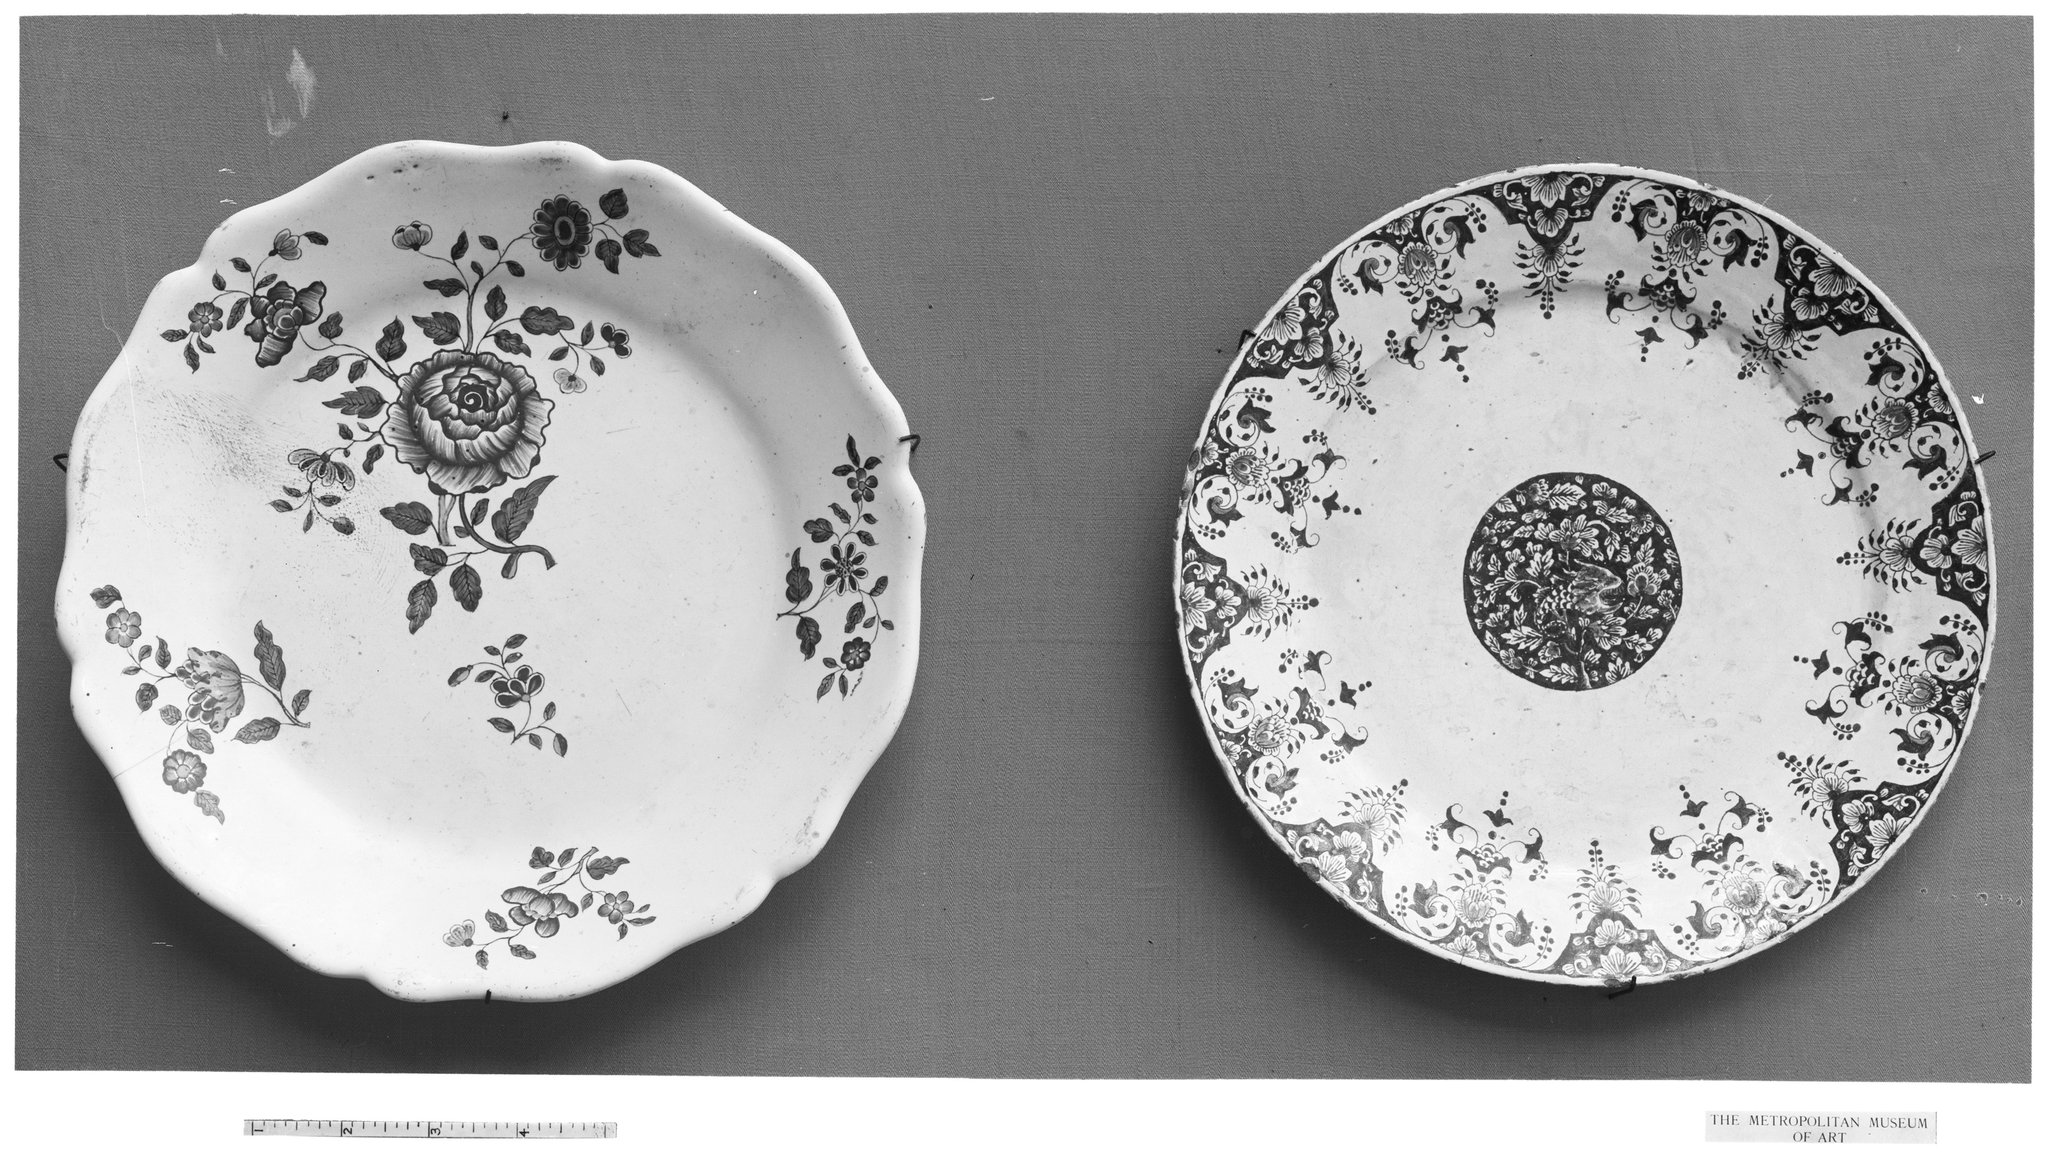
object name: plate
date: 1720-1750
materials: faience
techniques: glazing